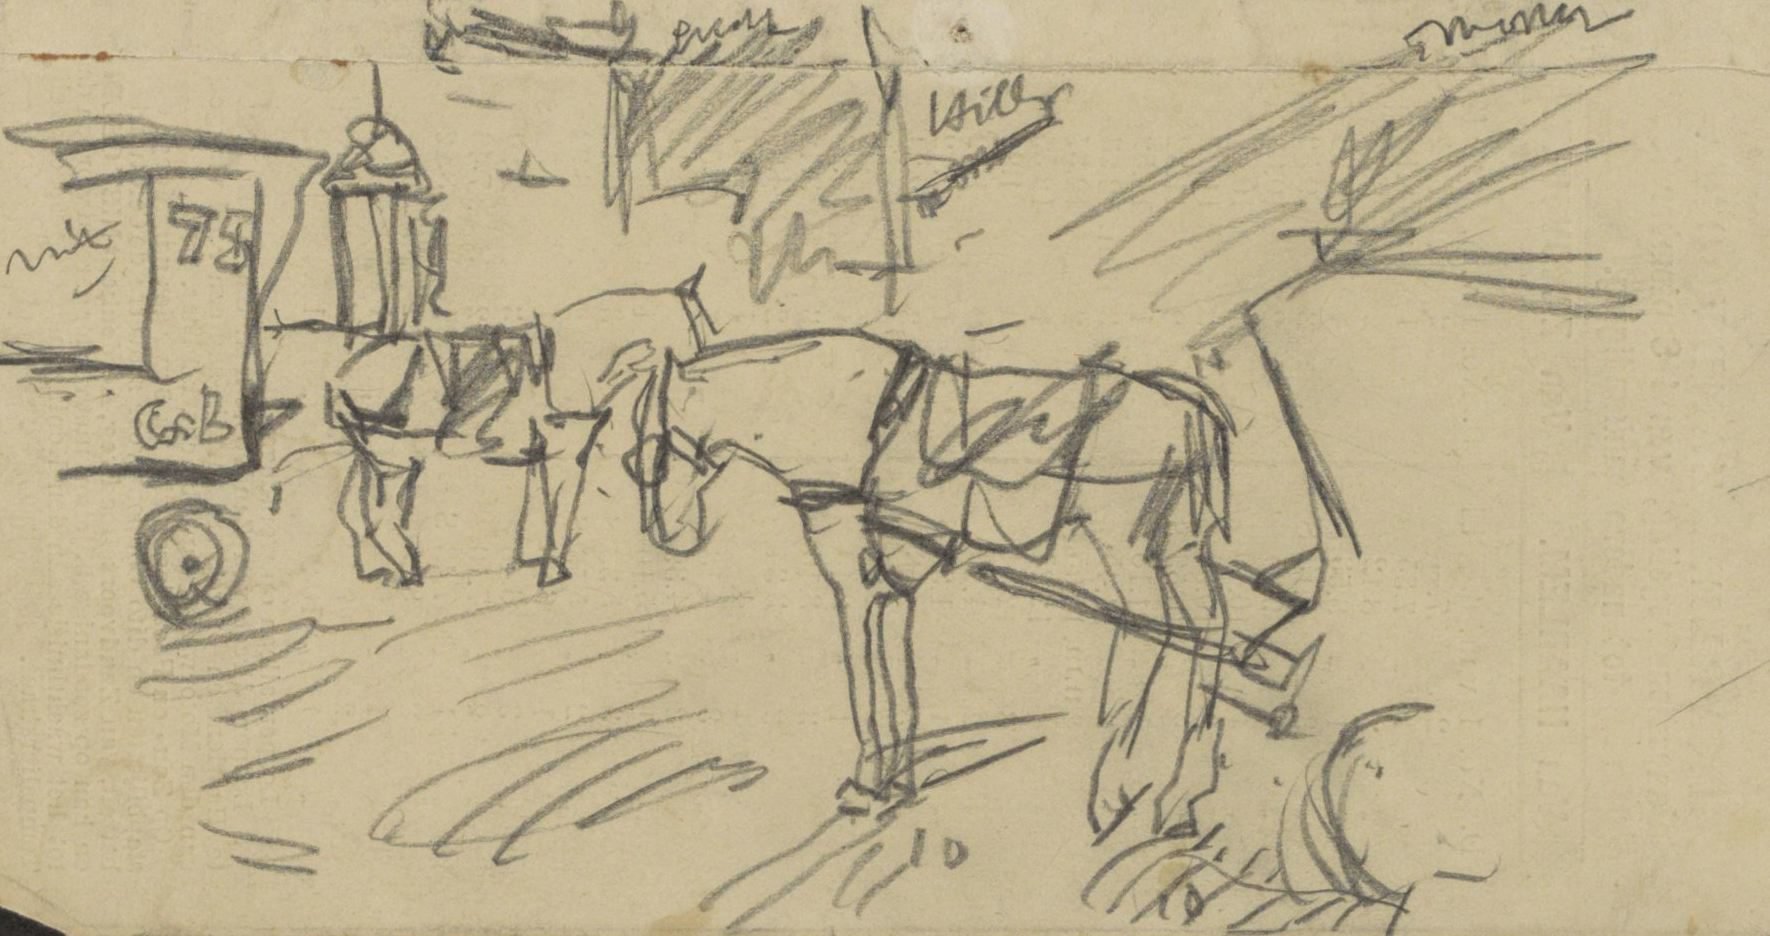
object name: drawing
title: Paardentrams in Amsterdam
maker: george hendrik breitner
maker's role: draughtsman, painter, print maker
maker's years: 1857-1923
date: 1904-1923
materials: paper, pencil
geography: amsterdam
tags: diligence, omnibus, horse-tram, city-view, and landscape with man-made constructions, amsterdam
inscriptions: kleurnotitie, handgeschreven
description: Verso de najaarsdienstregeling van de treinen op het traject Haarlem-Zandvoort per 1 september 1904.